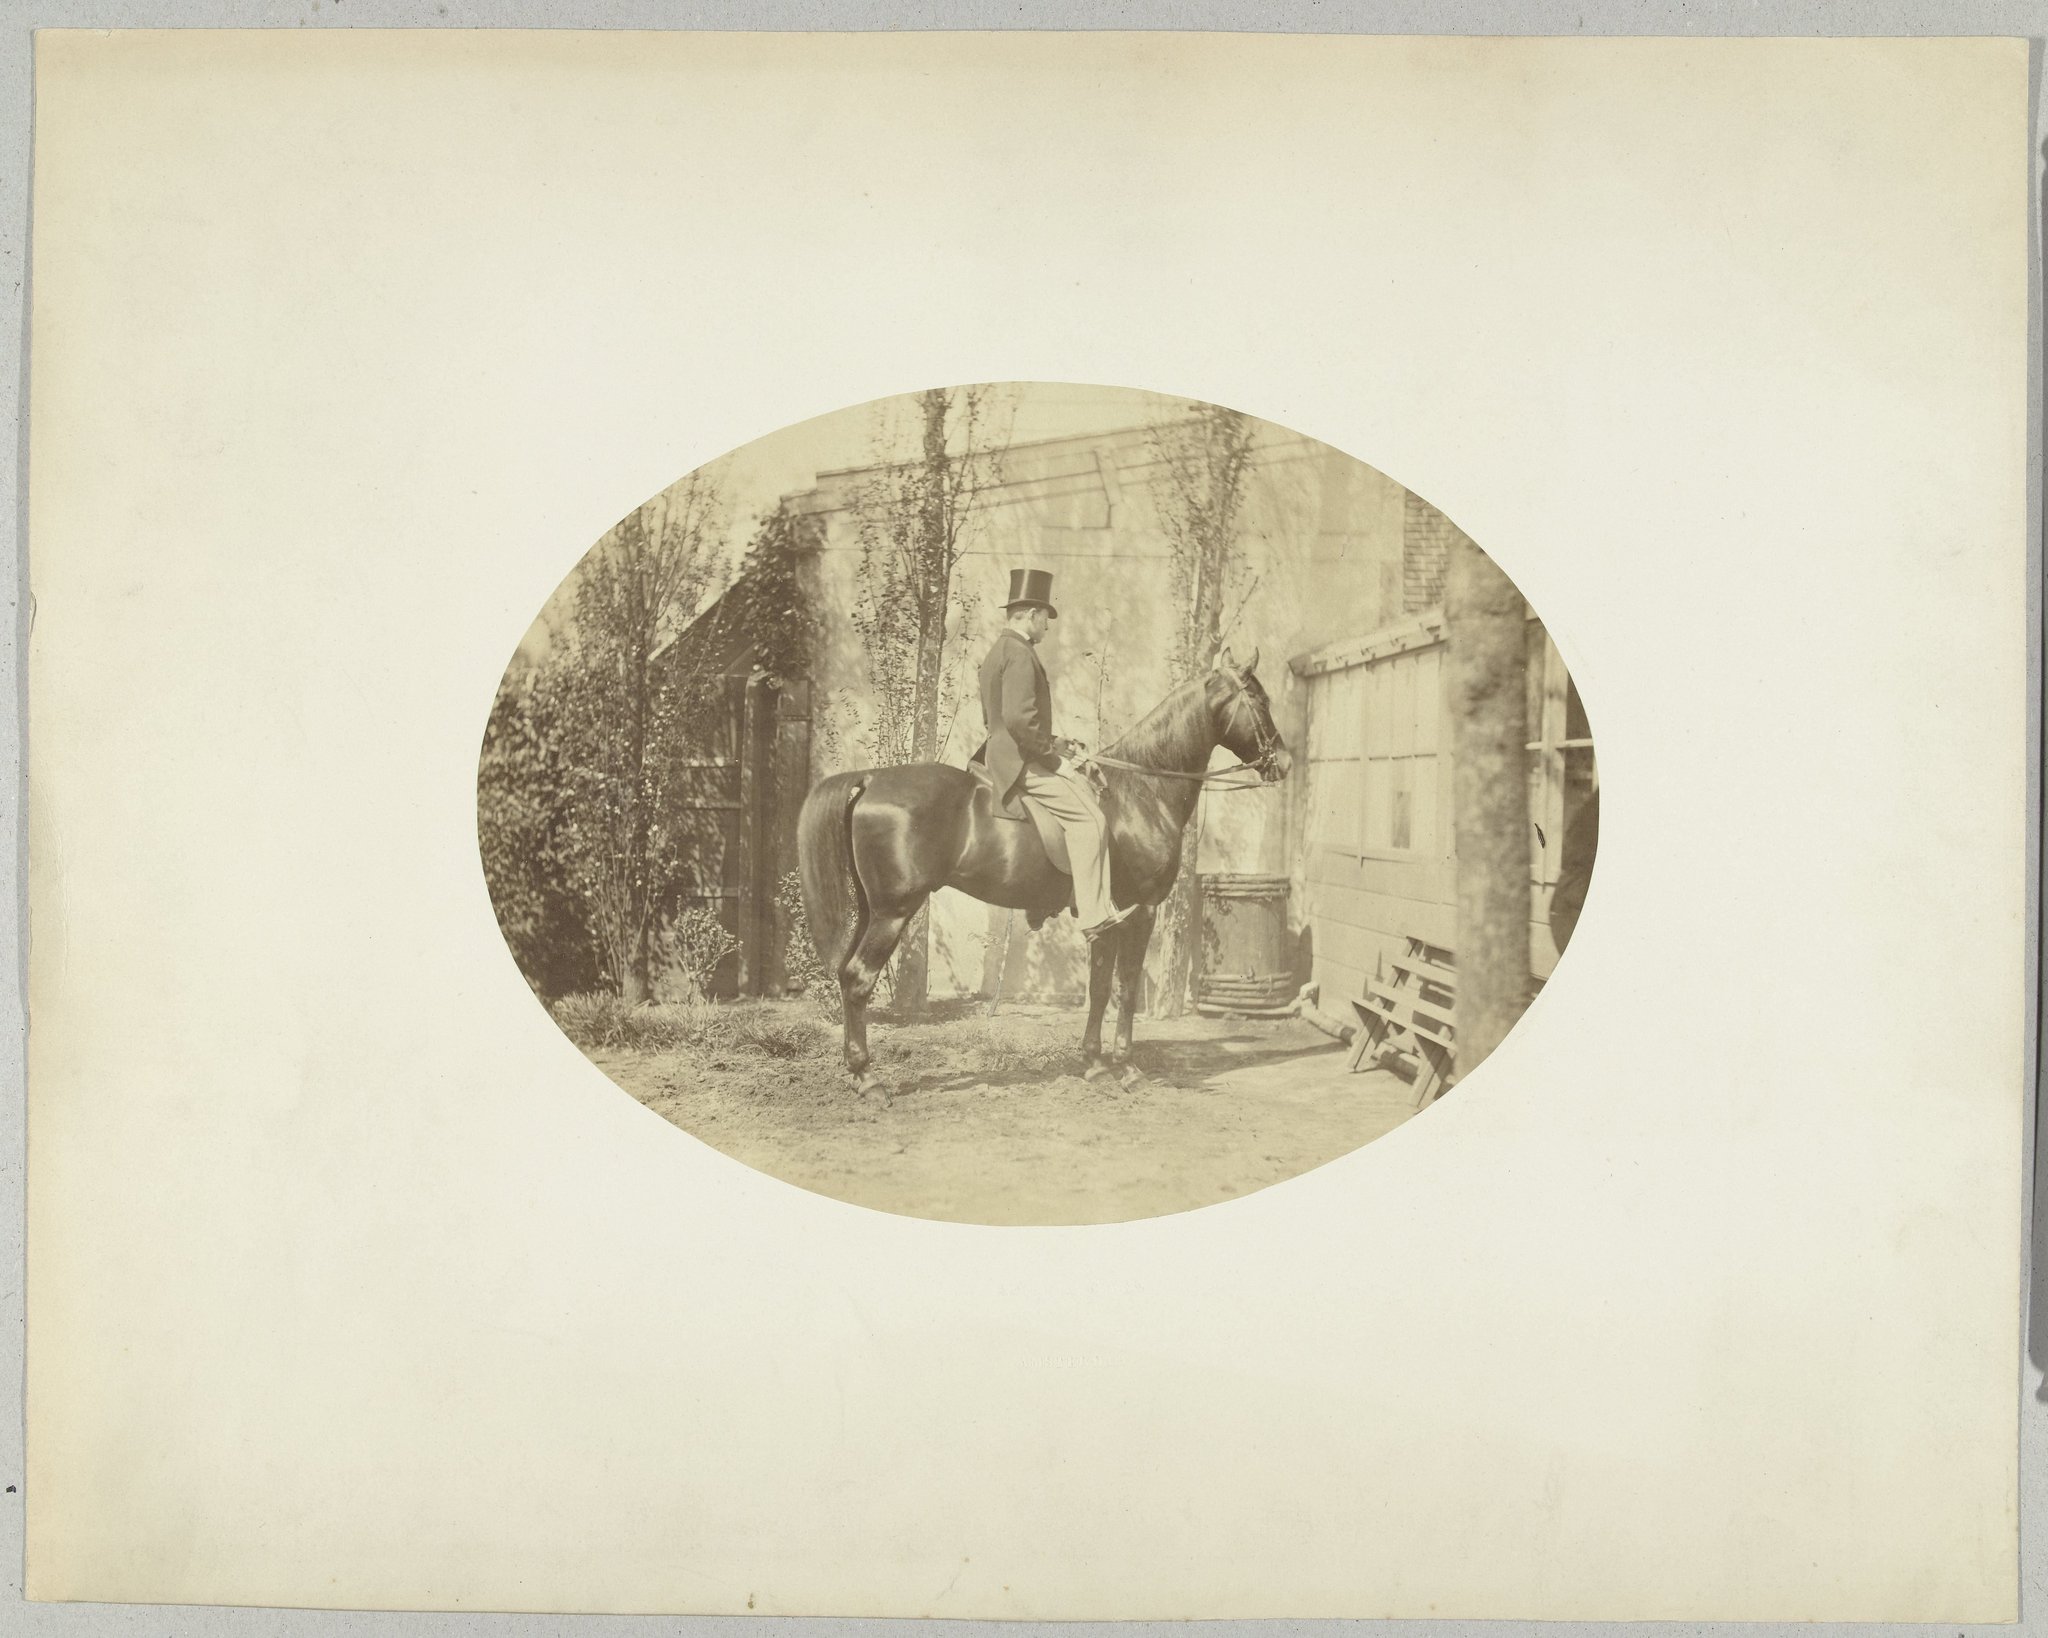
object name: photograph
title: Ovaal ruiterportret (mogelijk A.E. Simon Thomas)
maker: matthijs adolph conen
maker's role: painter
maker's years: 1833-1894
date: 1861-1894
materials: cardboard, paper, photographic support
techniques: albumen print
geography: amsterdam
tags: anonymous historical person portrayed, horse, netherlands